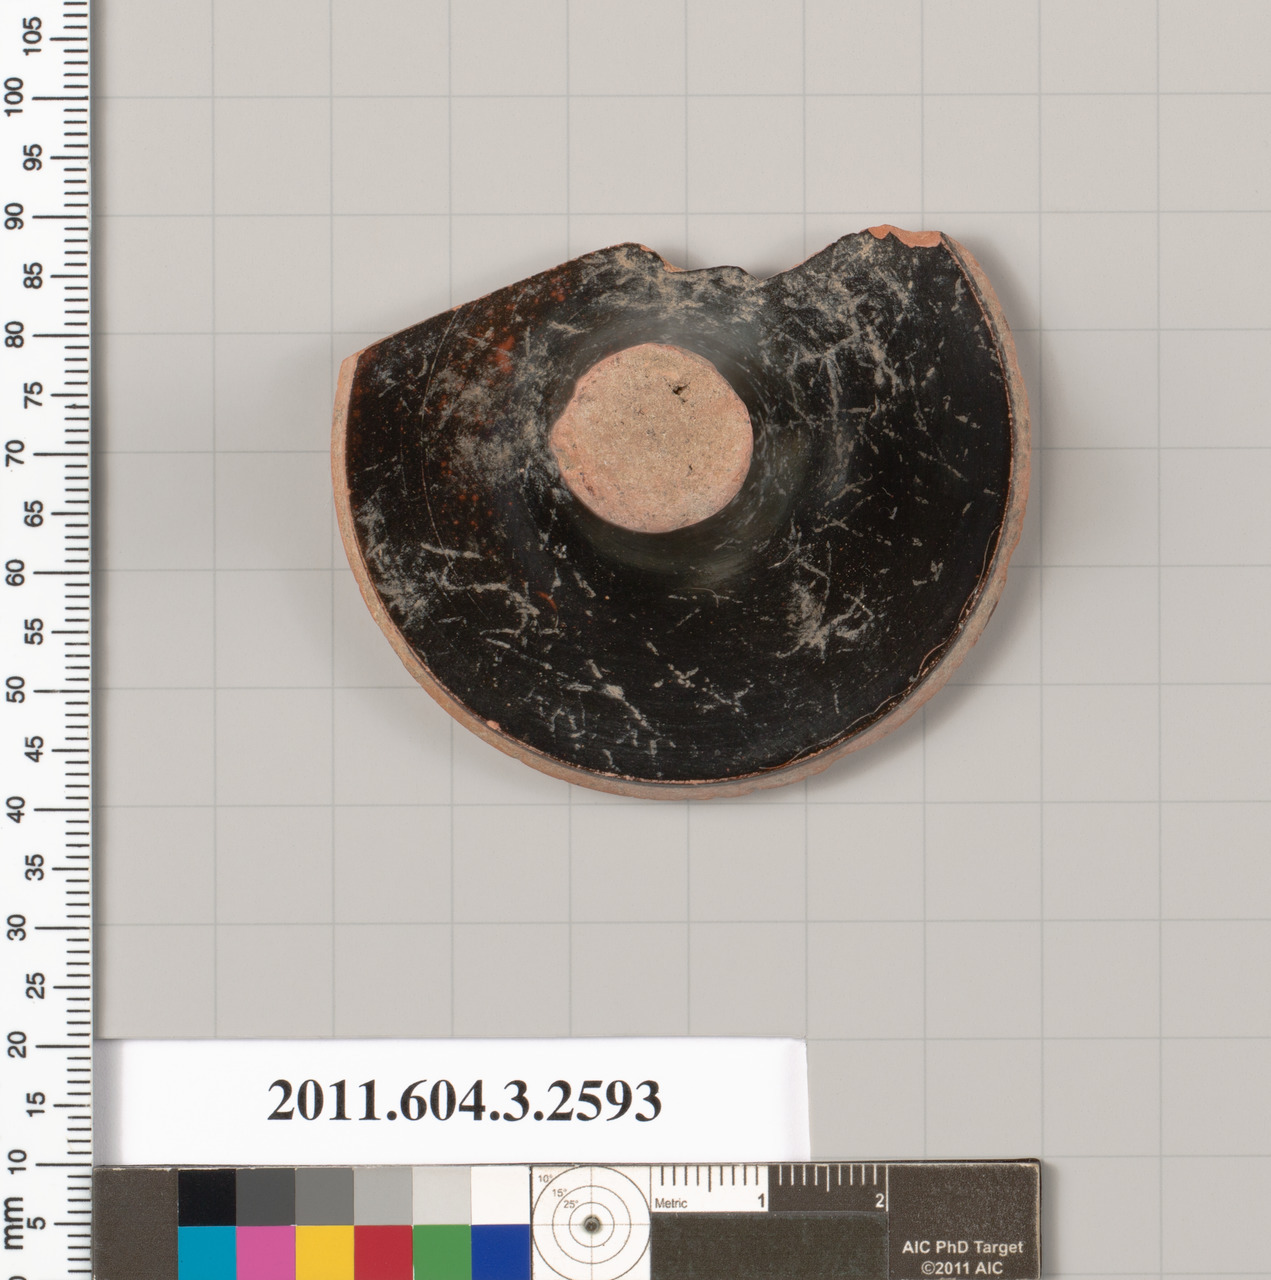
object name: kylix fragment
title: Terracotta fragment of a kylix (drinking cup)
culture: greek, attic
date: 575-525 BCE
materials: terracotta